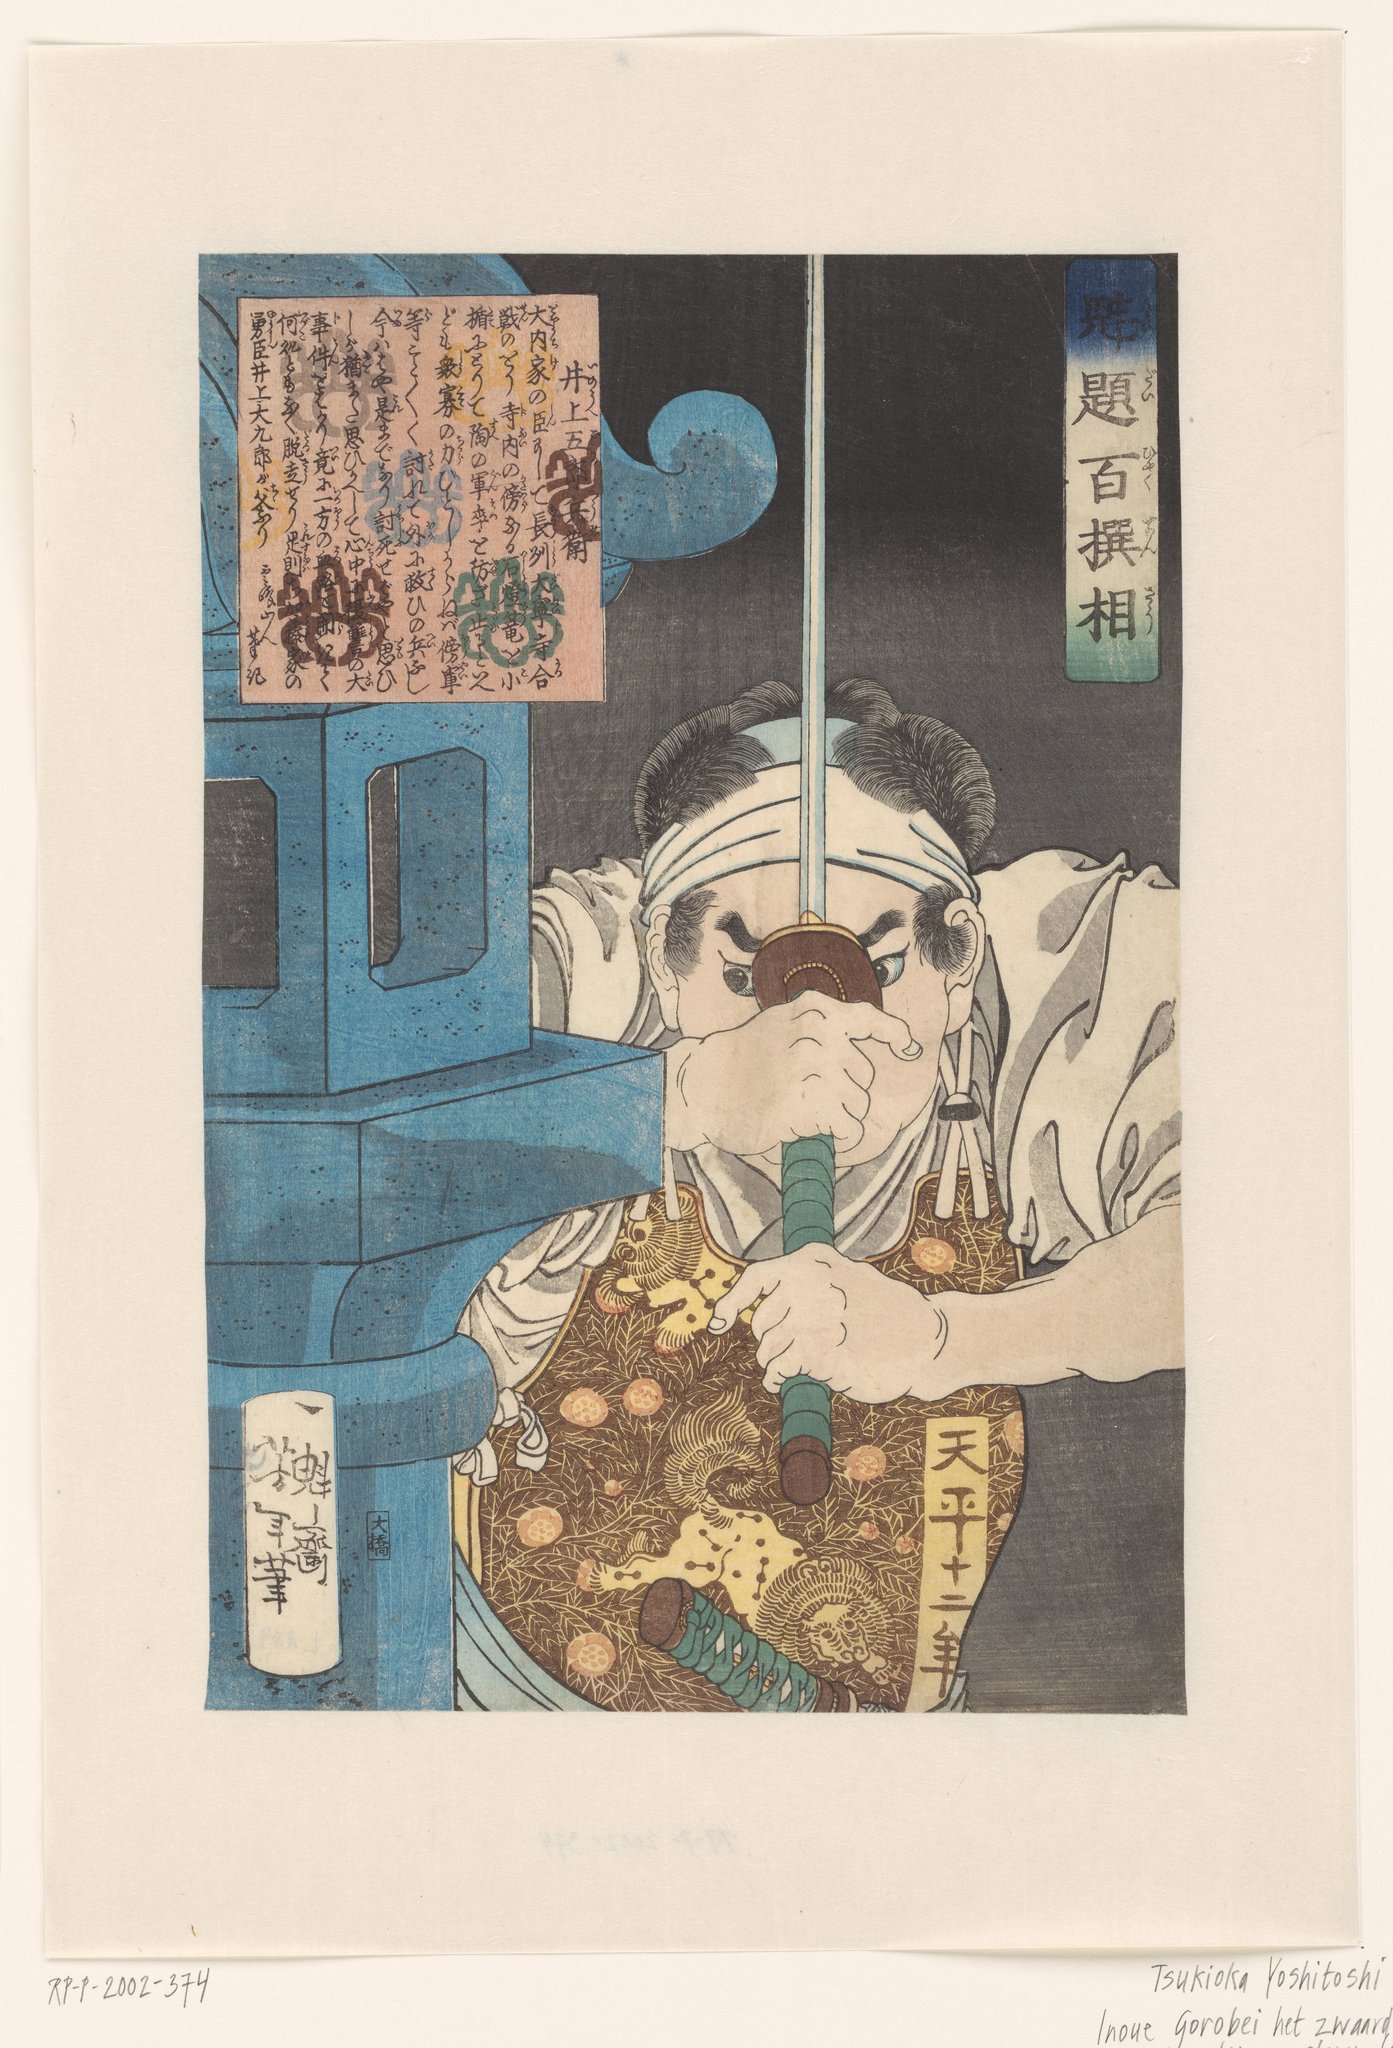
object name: print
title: Inoue Gorobei het zwaard heffend bij een stenen lantaarn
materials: paper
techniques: woodcut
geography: tokyo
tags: lantern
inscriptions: collector's mark: Lugt 2228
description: Inoue Gorobei, in harnas met leeuw motief, heft zijn zwaard bij een stenen lantaarn.